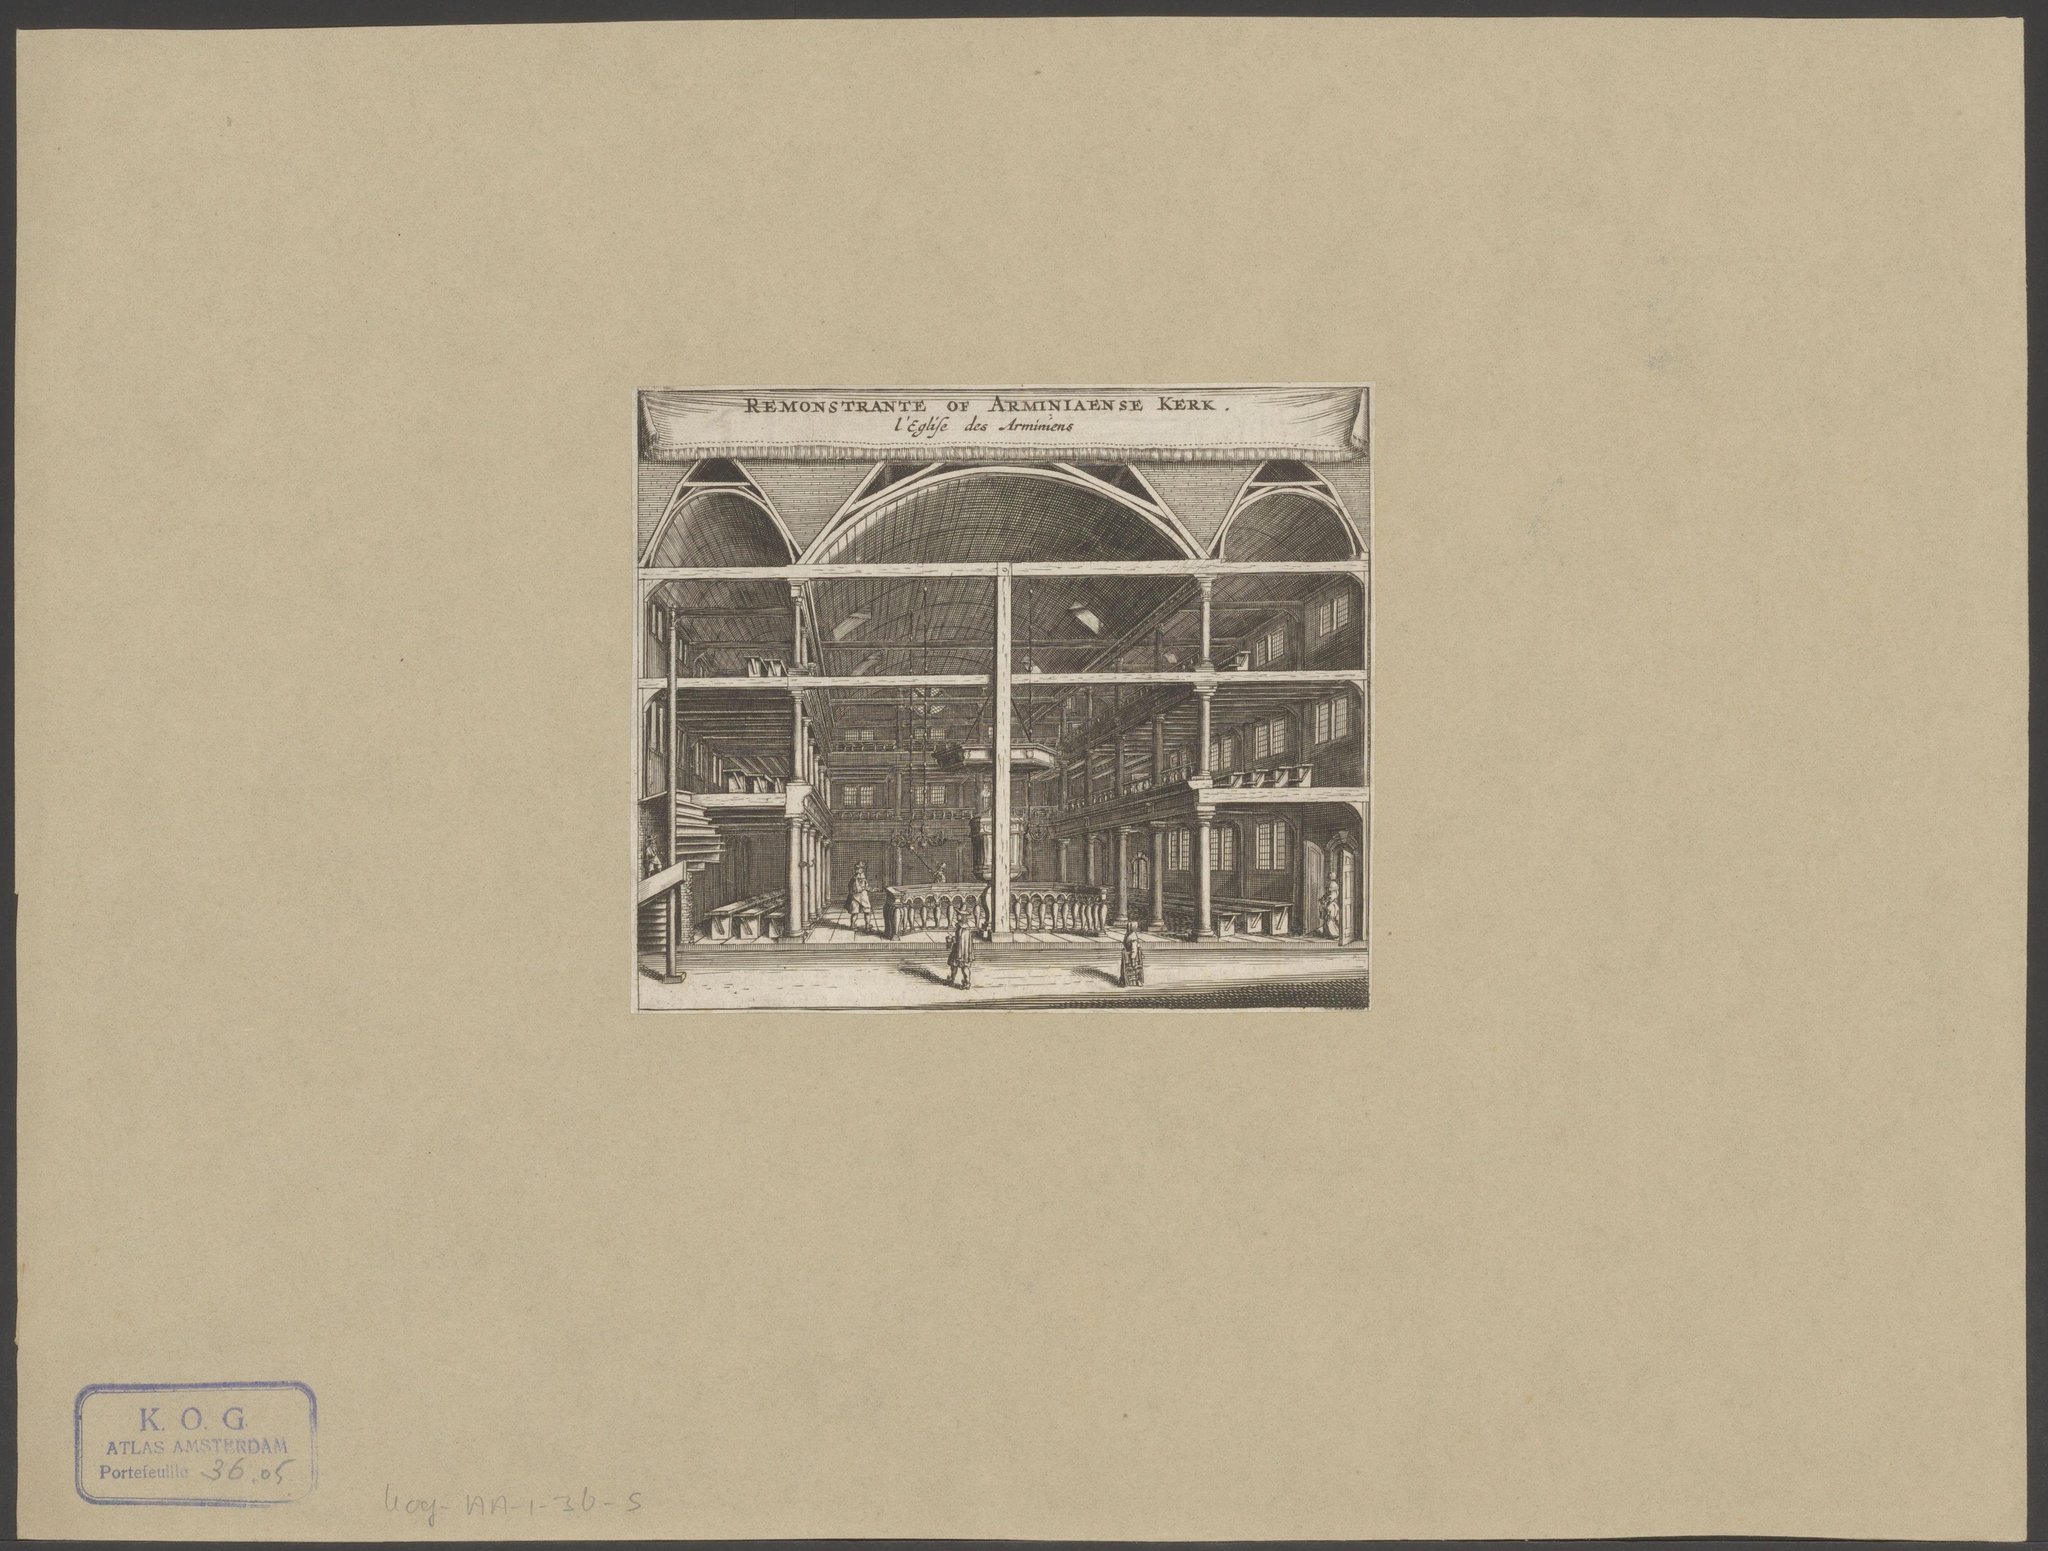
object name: print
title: Interieur van de Remonstrantse (Arminiaanse) Kerk te Amsterdam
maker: jan veenhuysen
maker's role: print maker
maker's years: 1625-1693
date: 1665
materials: paper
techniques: engraving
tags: protestant churches and denominations (with name), interior of church, amsterdam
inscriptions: collector's mark: Lugt 1641b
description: Huidige tweede bekende staat (met toevoeging Franse titel) ook gebruikt in: Domselaer, Tobias en Isaac Commelin. Beschryvinge van Amsterdam : haar eerste oorspronk uyt den huyze der heeren van Aemstel en Aemstellant (…). 6 dln. Amsterdam: Marcus Willemsz van Doornick, 1665. Eerste staat van prent ook gebruikt in: Fockens, Melchior. Beschrijving Der wijdt-vermaarde Koop-stadt Amstelredam, Van haar eerste beginselen, zedert den Jare 1203. oude Voorrechten, verscheyde Vergrootingenoude Voor-rechten, en verscheyde Vergrootingen (…). 3de druk. Amsterdam: Marcus Willemsz. Doornick, 1664. En in: Zesen, Philipp von. Beschrybung der Weidtberuhmde Kauf-Stadt Amstelredam / Beschreibung der Stadt Amsterdam darinnen von derselben ersten ursprunge bis auf gegenwartigen zustand (…). Amsterdam: Marcus Willemsz. Doornick, 1664. Derde bekende staat (rechtsboven genummerd: 18) ook gebruikt in verschillende latere zeventiende- en achttiende-eeuwse publicaties.